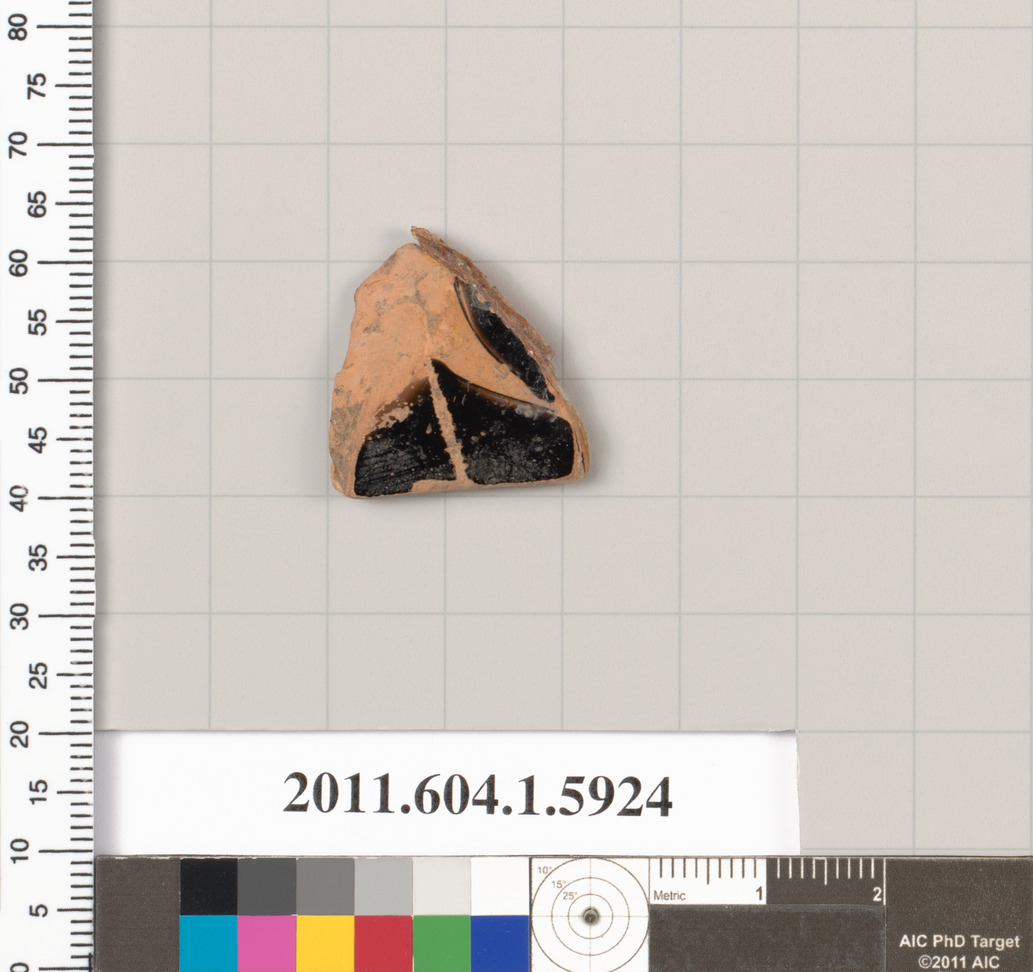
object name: kylix fragment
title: Terracotta fragment of a kylix (drinking cup)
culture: greek, attic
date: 520-510 BCE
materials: terracotta